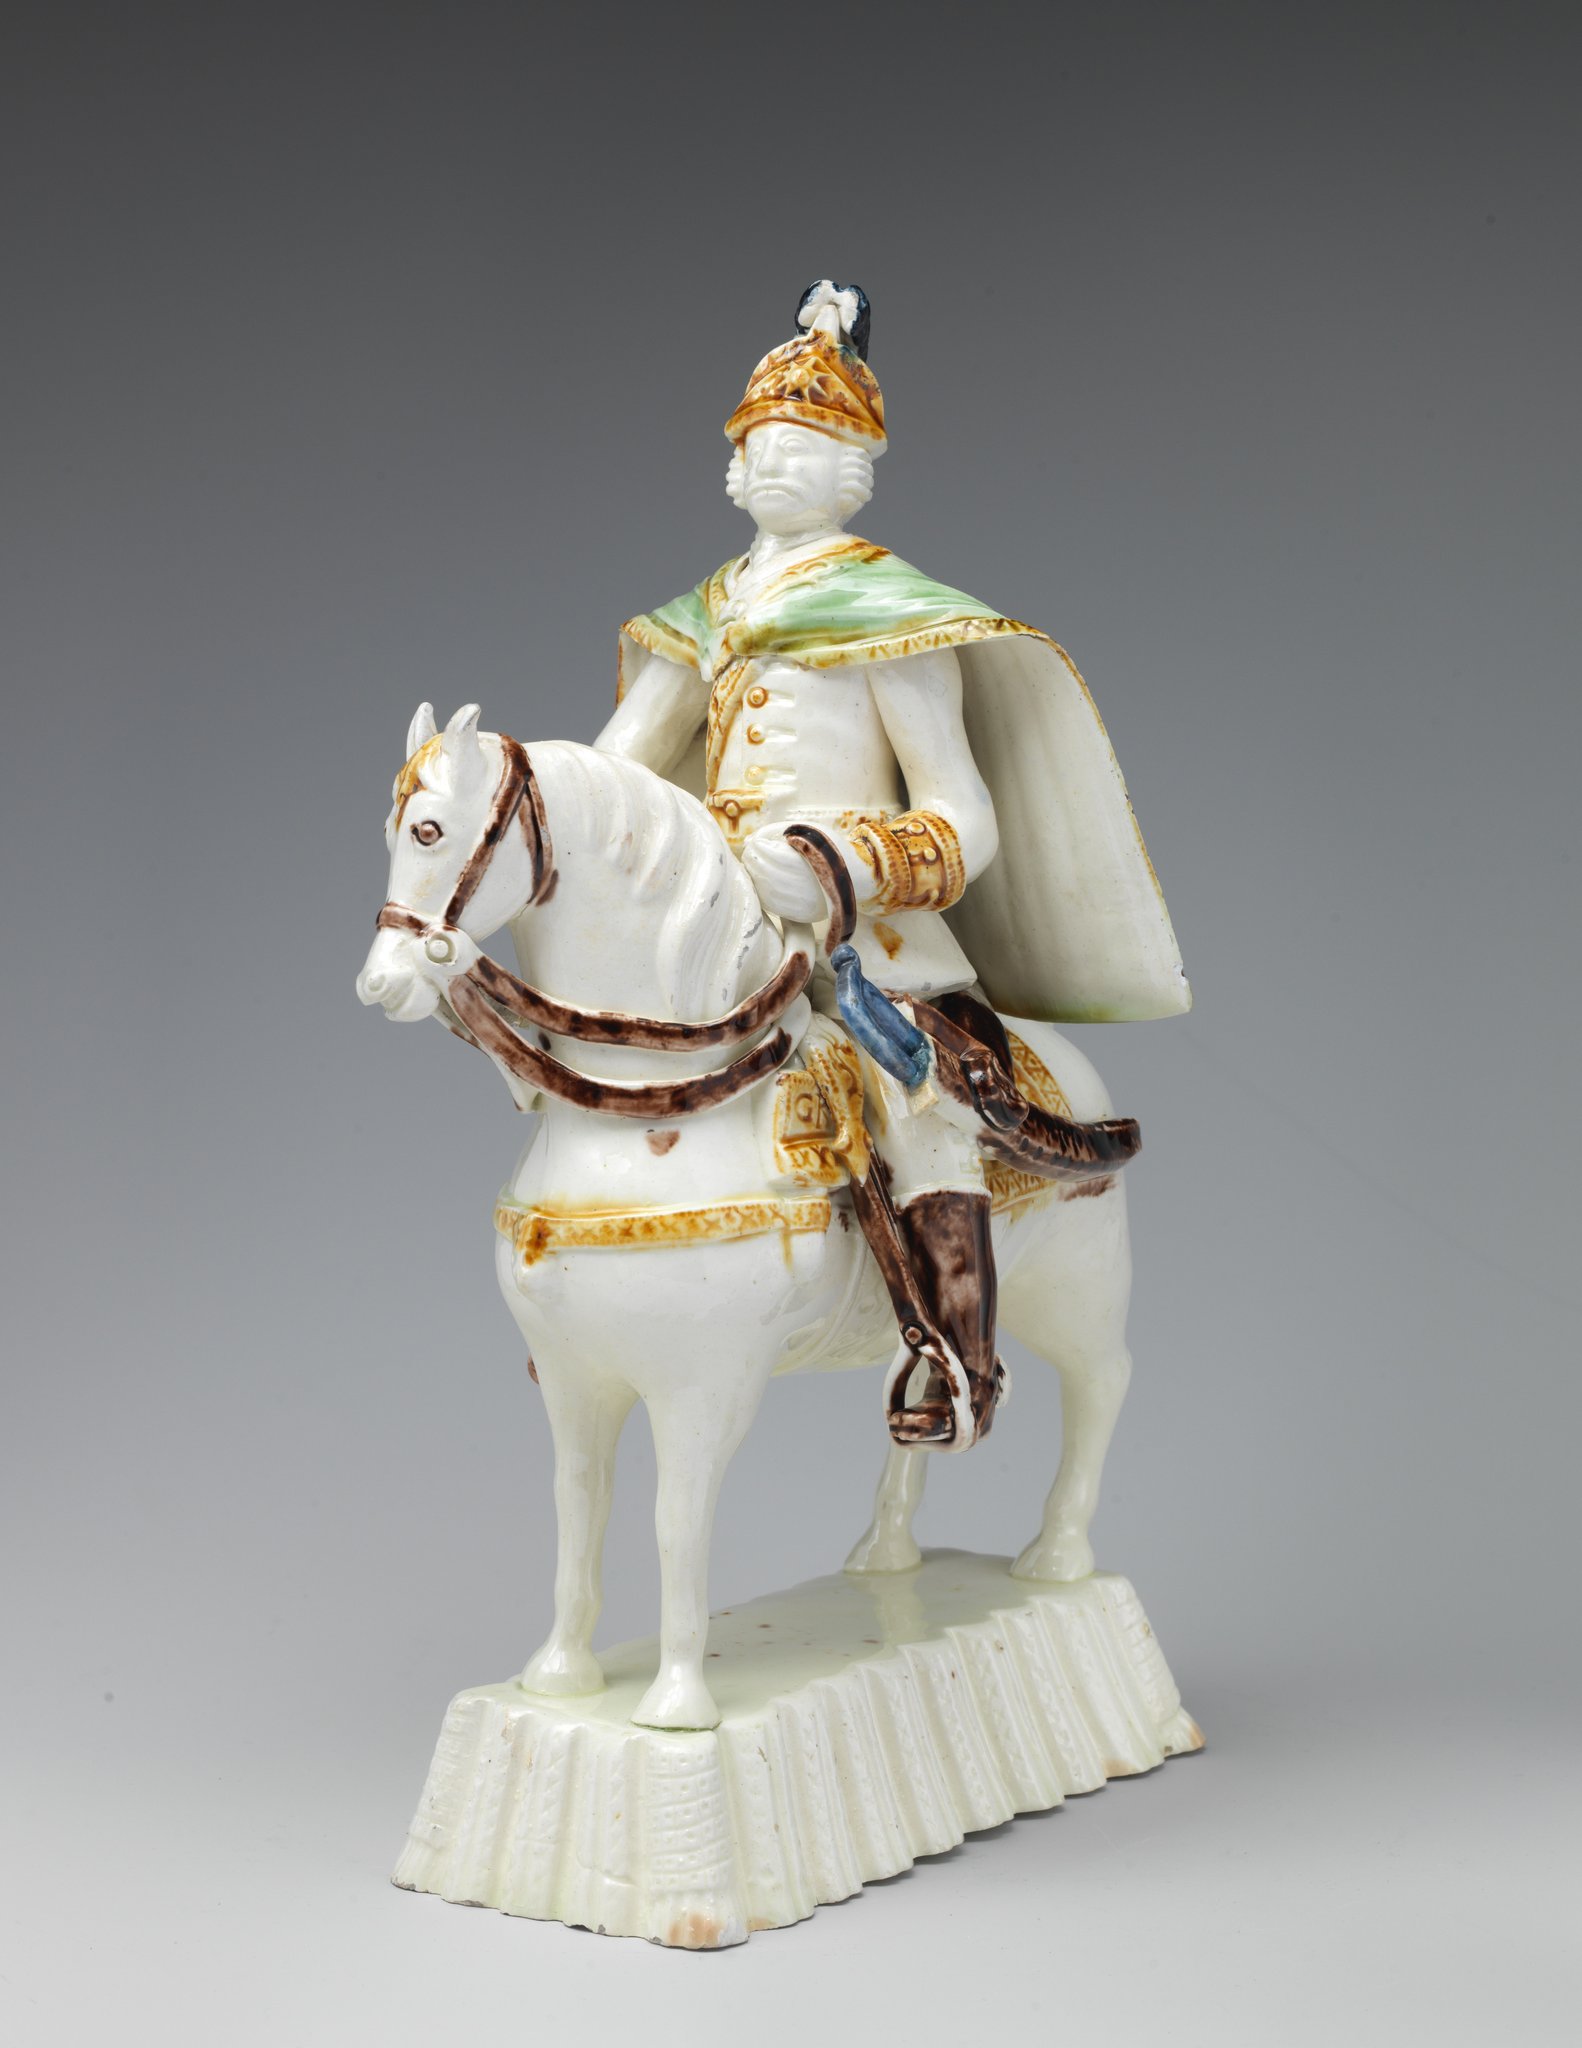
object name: figure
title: Cavalryman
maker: astbury-whieldon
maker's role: maker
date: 1750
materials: earthenware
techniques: glazing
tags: men,horses